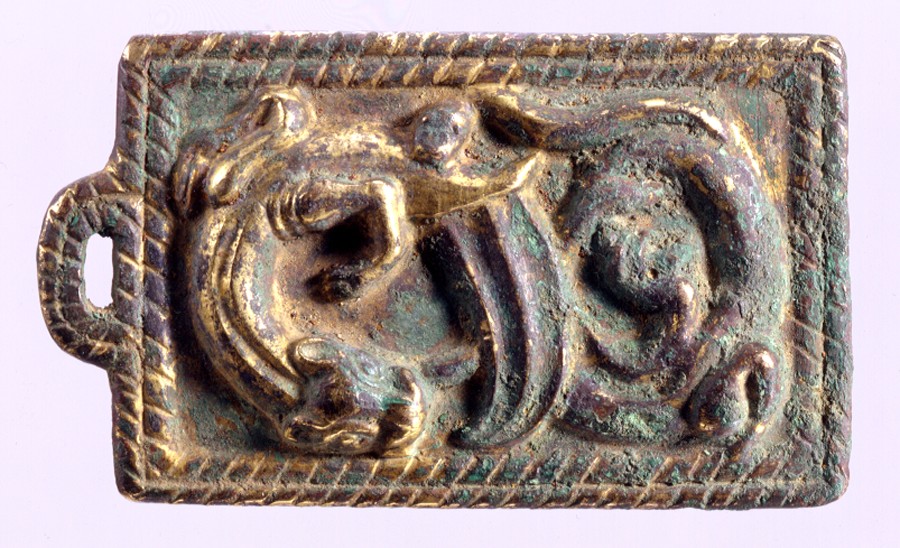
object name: belt plaque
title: Belt Plaque with Dragon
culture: north chinese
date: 200-101 BCE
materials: bronze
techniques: gilding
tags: dragons